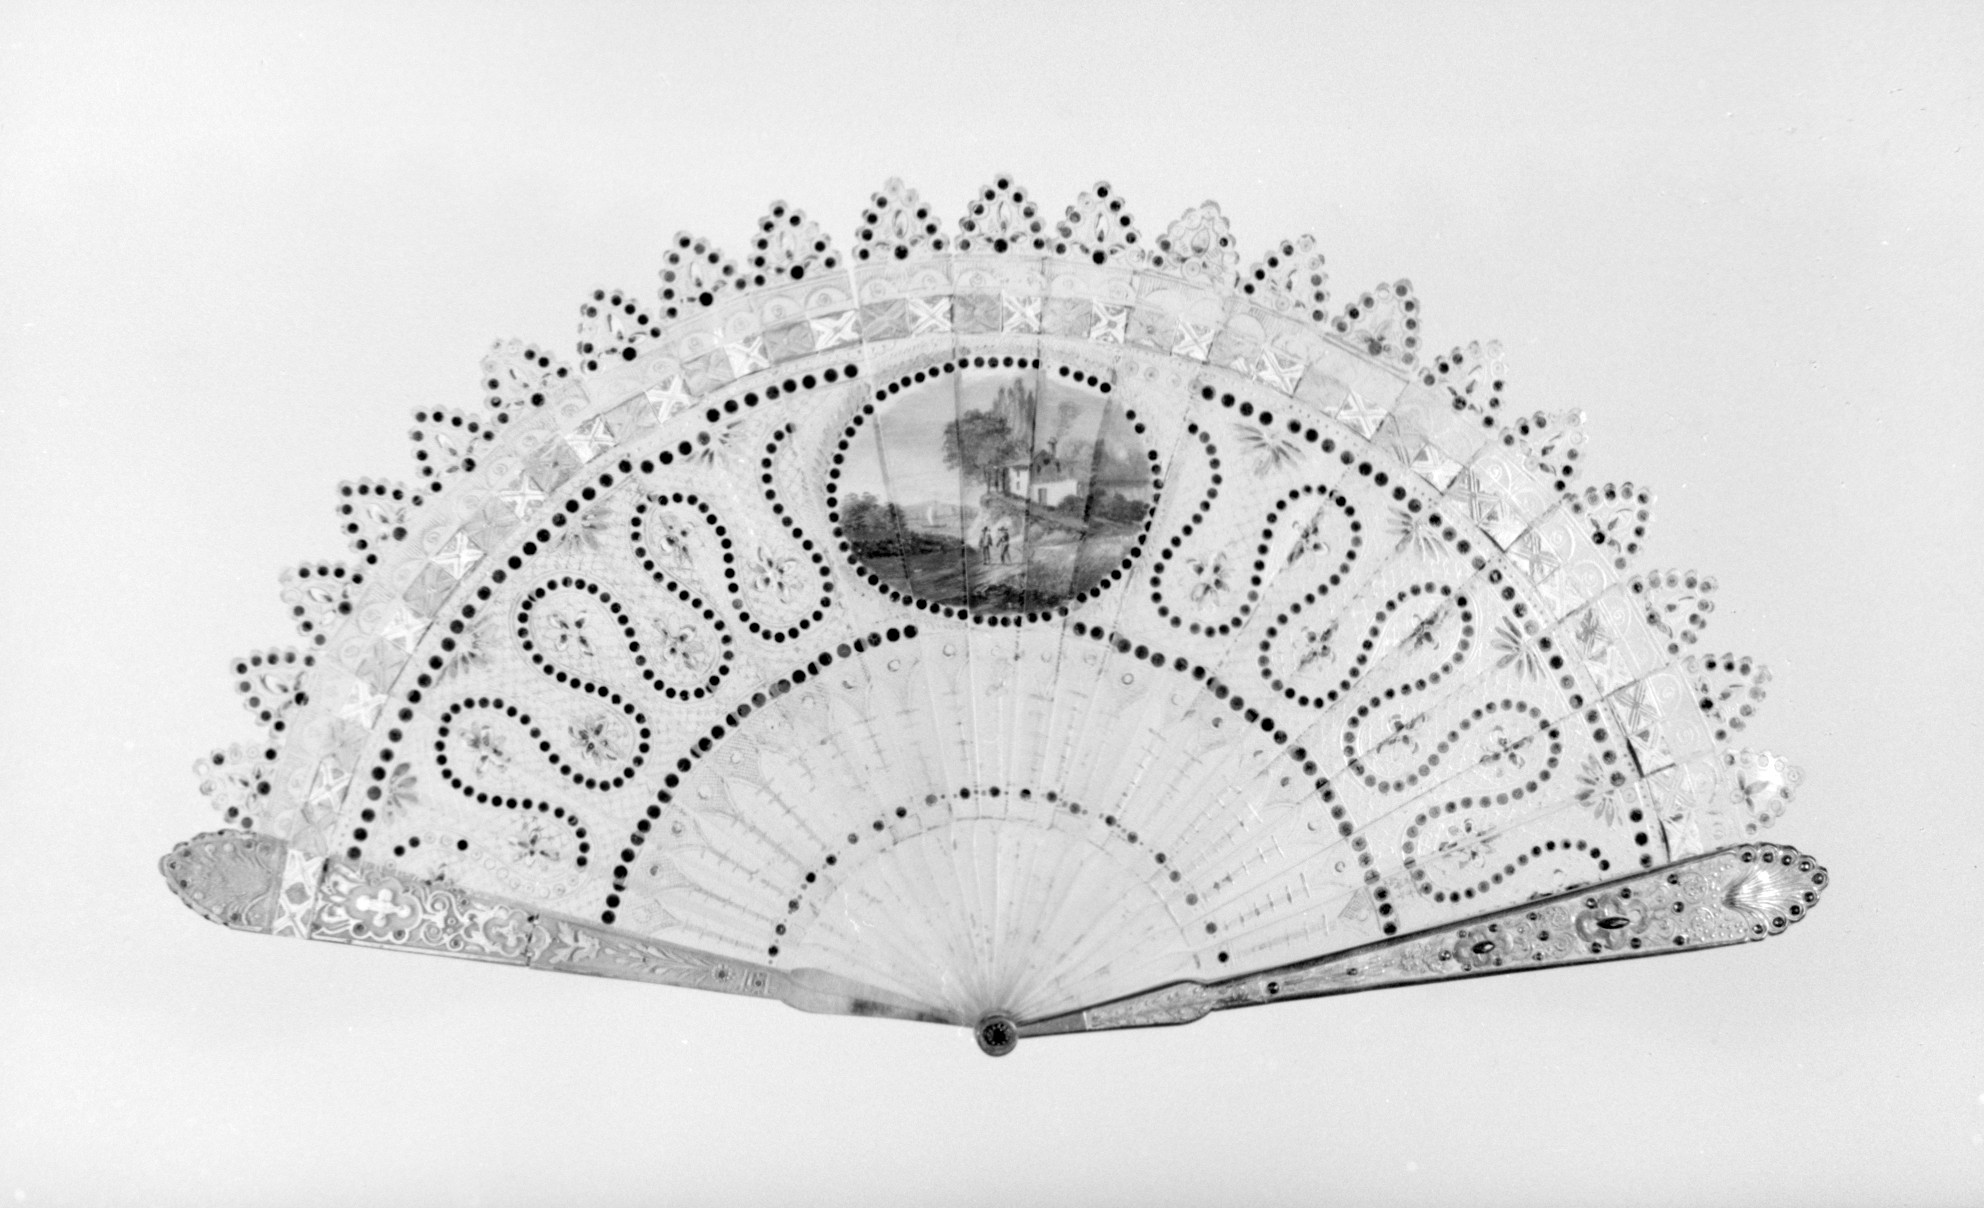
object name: fan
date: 1801-1833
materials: gilt, glass, horn, metal, paint, parchment, steel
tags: landscapes